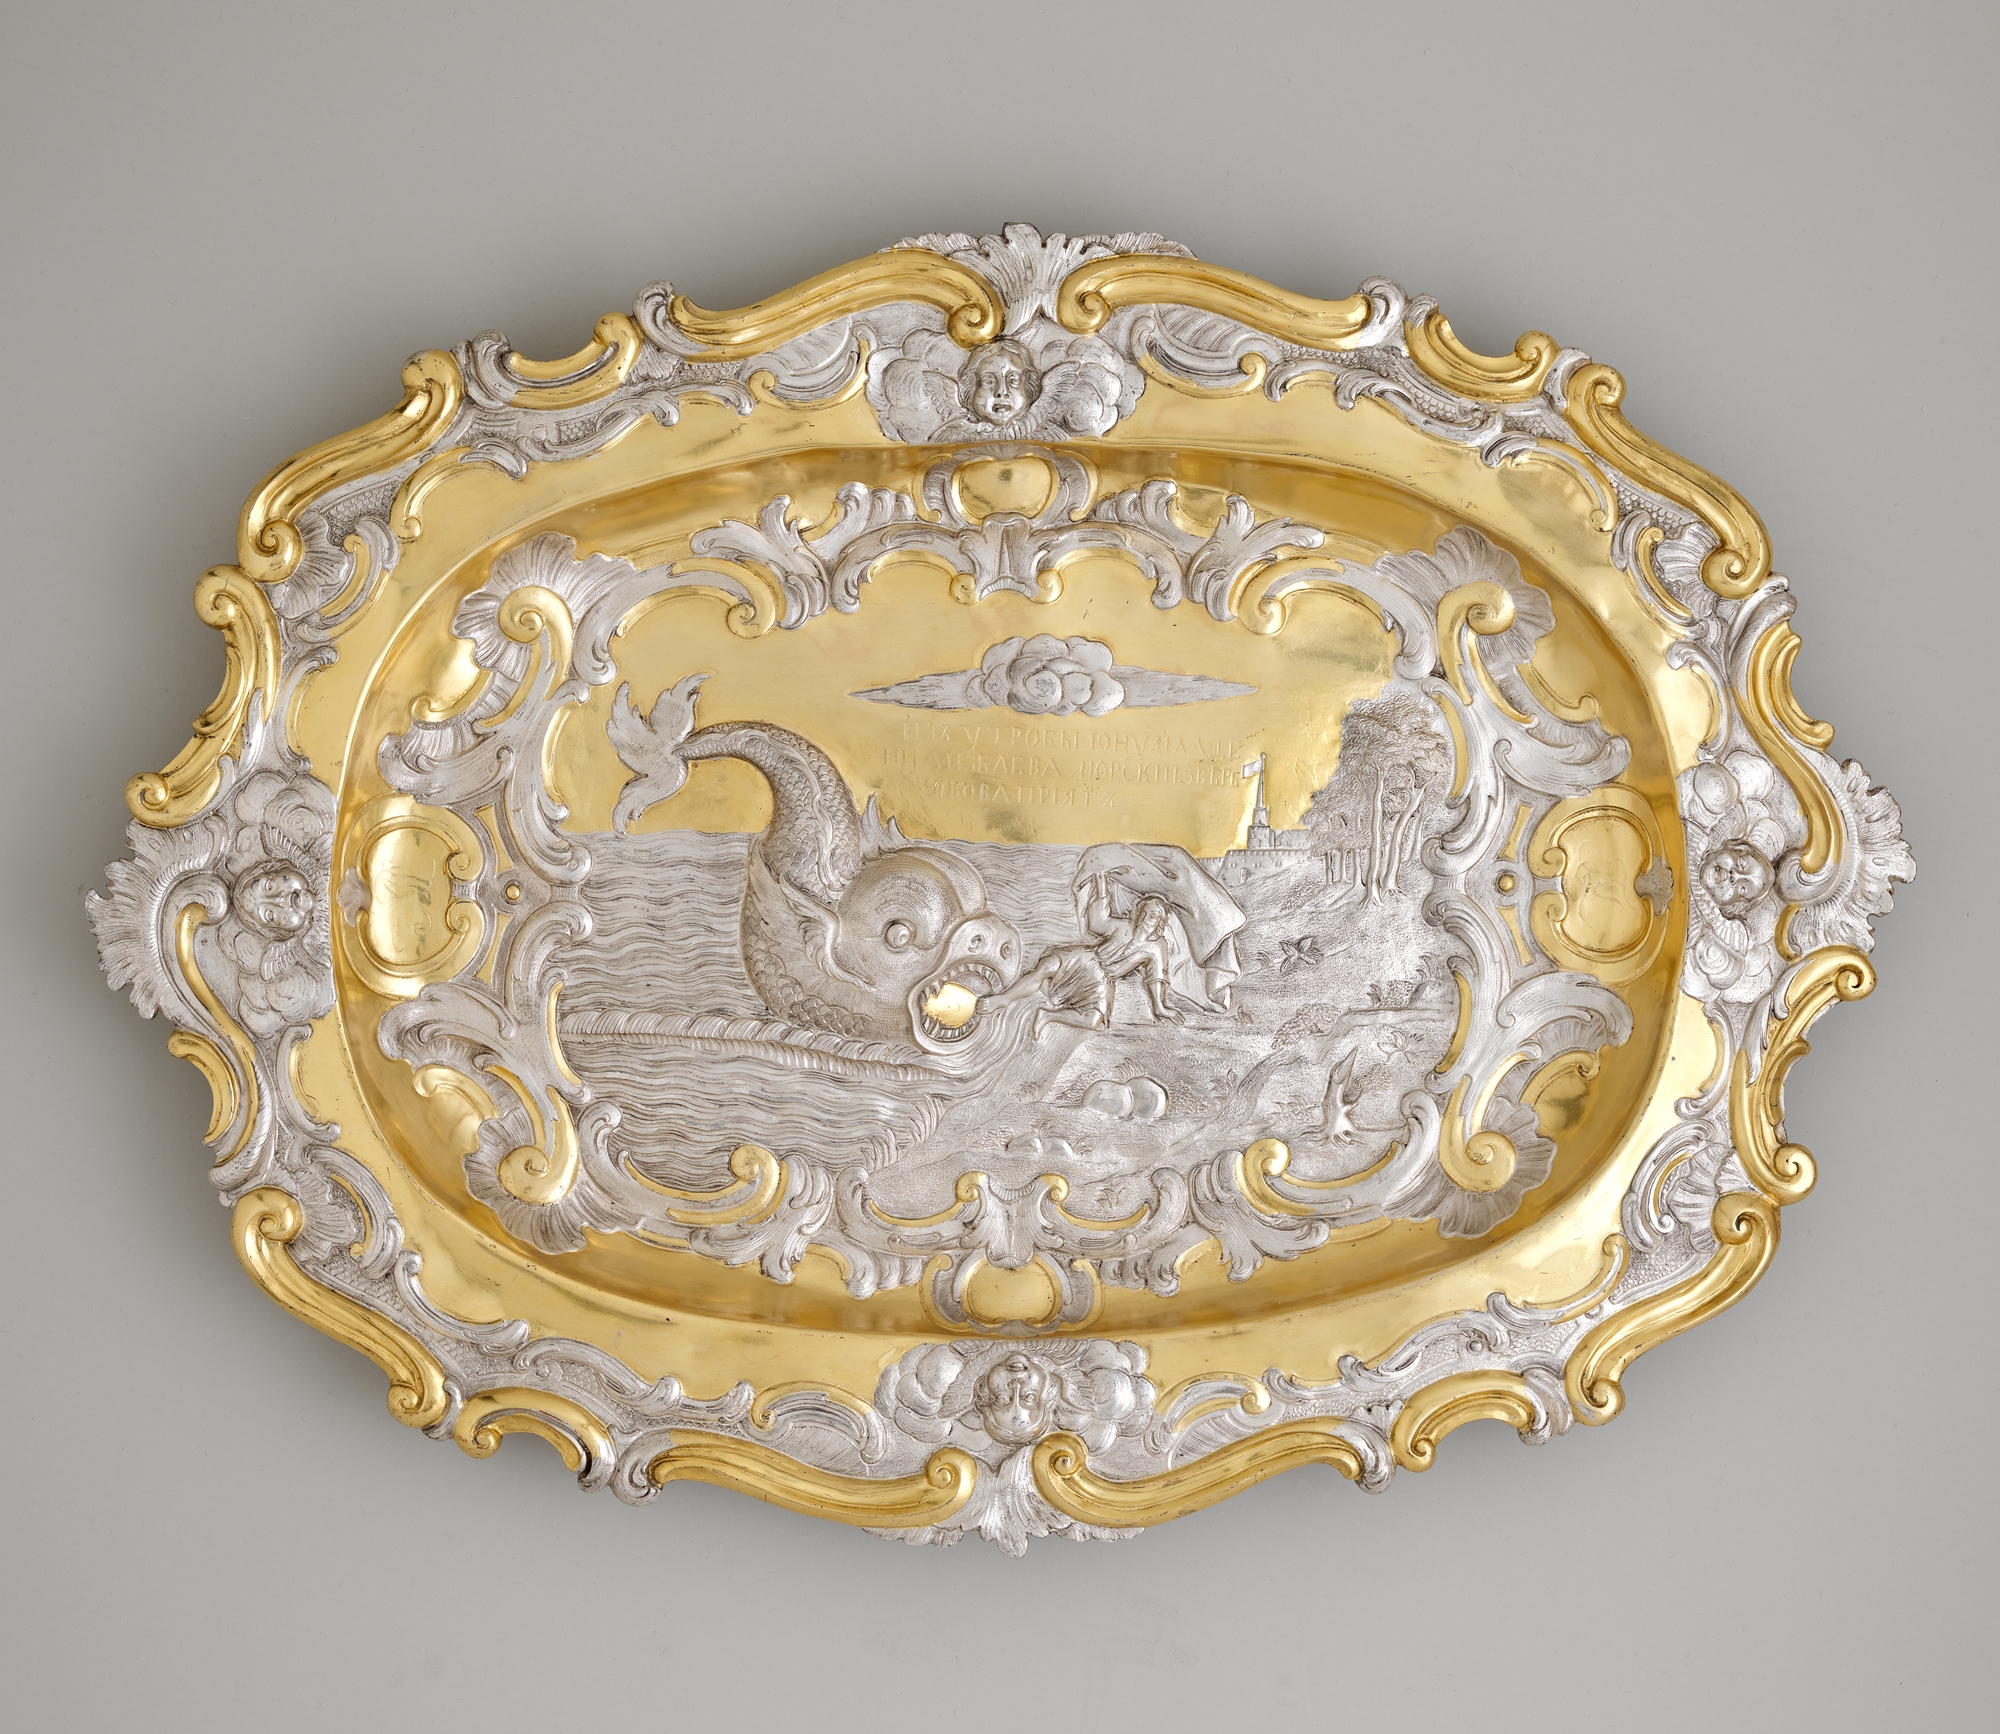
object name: salver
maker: elkington & co.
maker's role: manufacturer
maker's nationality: british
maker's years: 1829-1963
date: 1801-1900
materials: gilt, silver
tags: men,whales